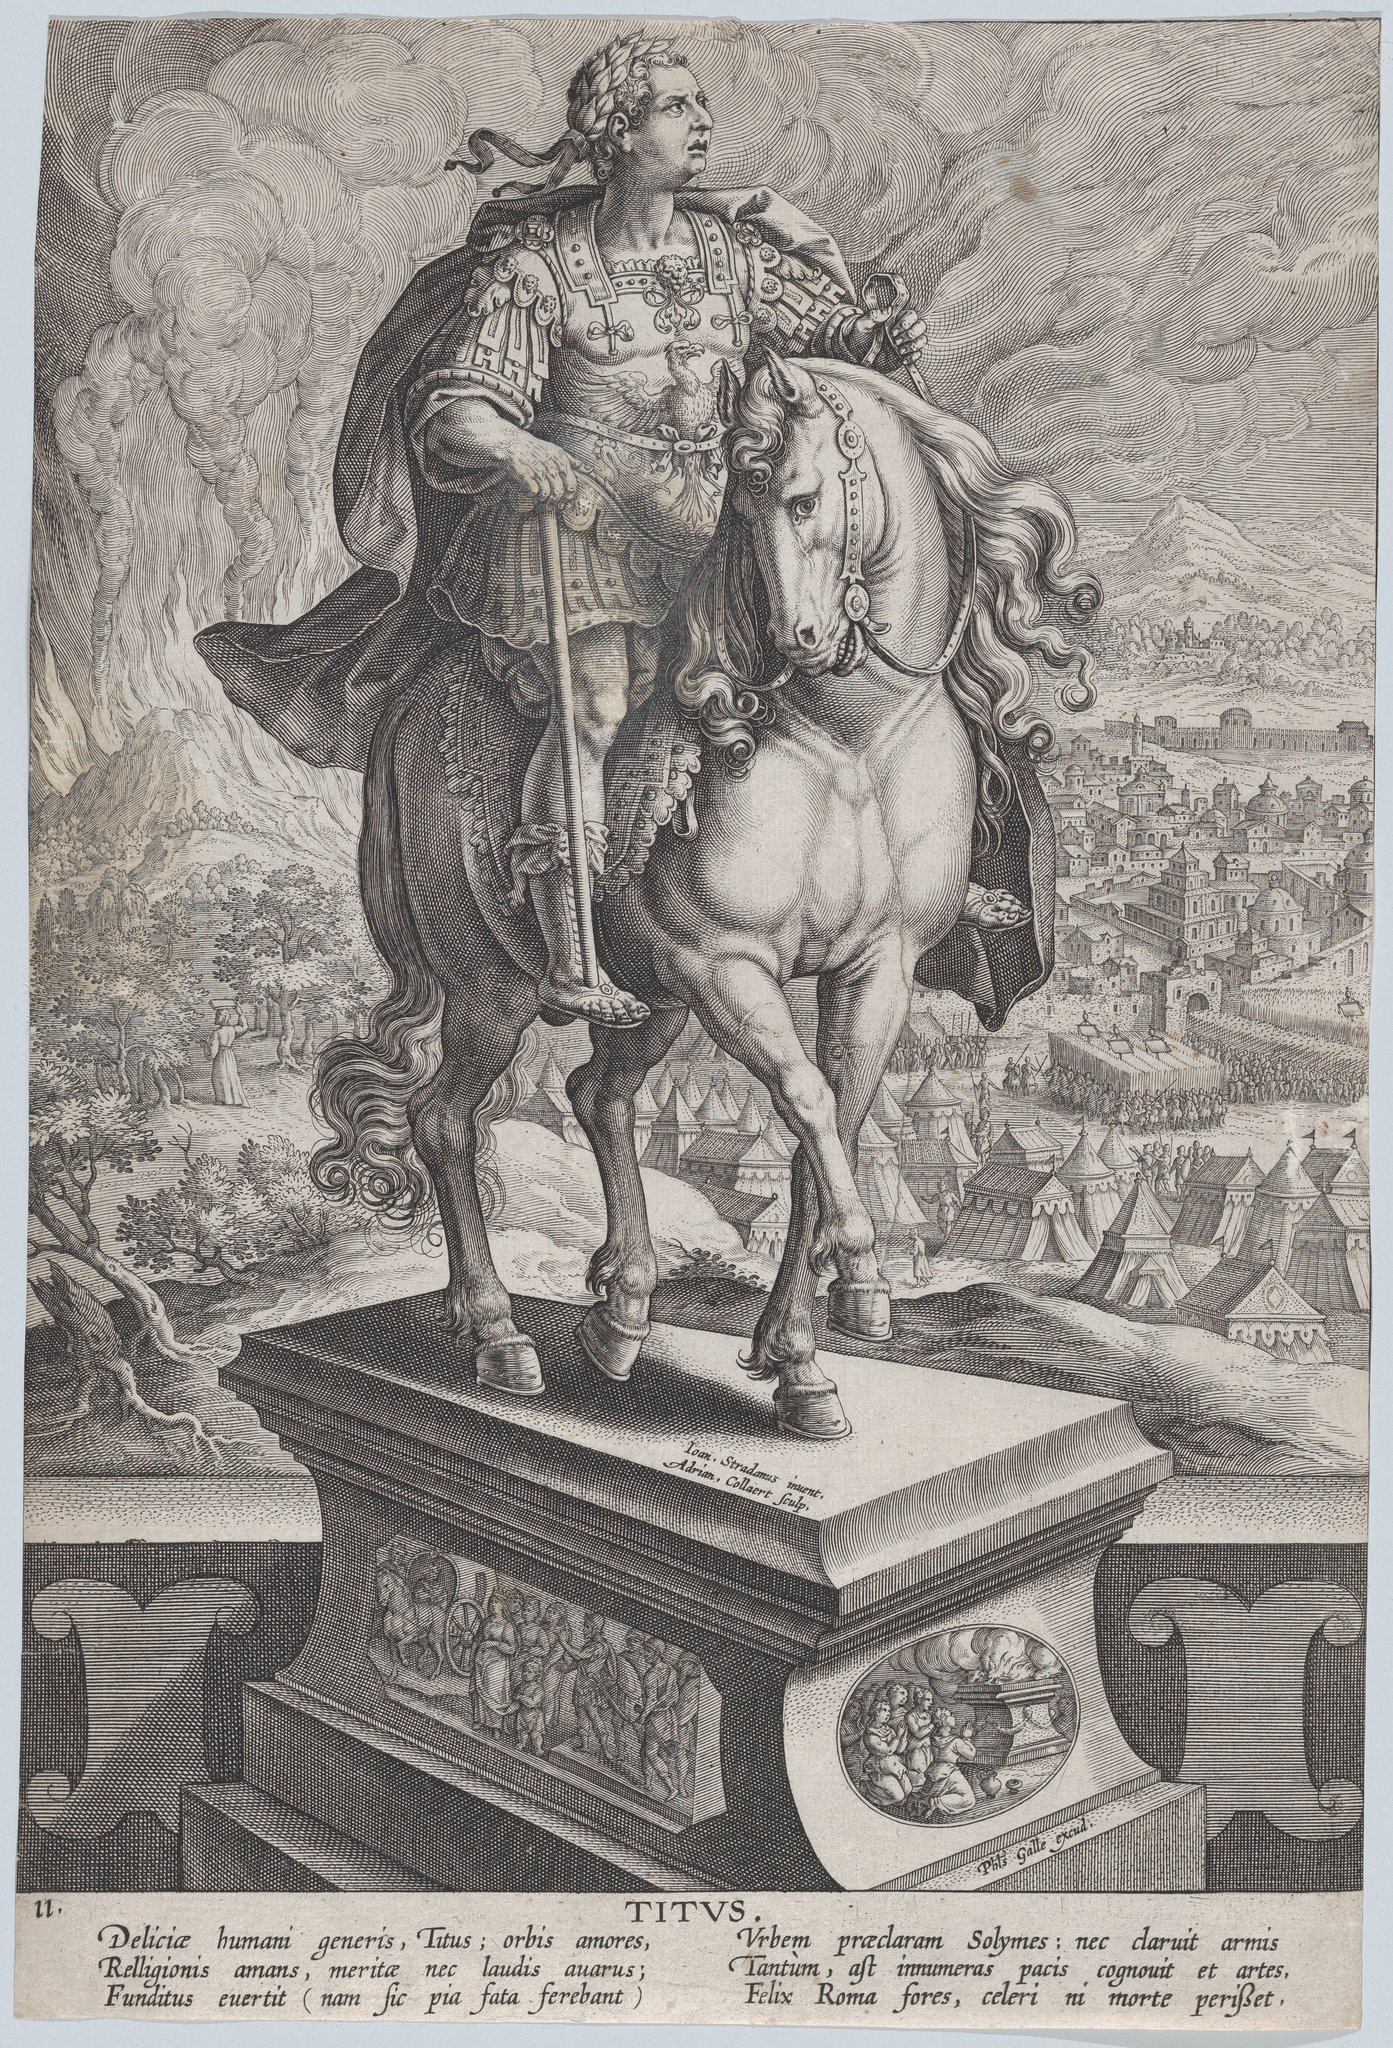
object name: print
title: Plate 11: equestrian statue of Titus, seen three-quarters to the right, Mount Vesuvius erupting at left in the background, from 'Roman Emperors on Horseback'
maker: adriaen collaert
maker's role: artist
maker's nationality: netherlandish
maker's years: 1560-1618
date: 1587-1589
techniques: engraving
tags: men,portraits,horses